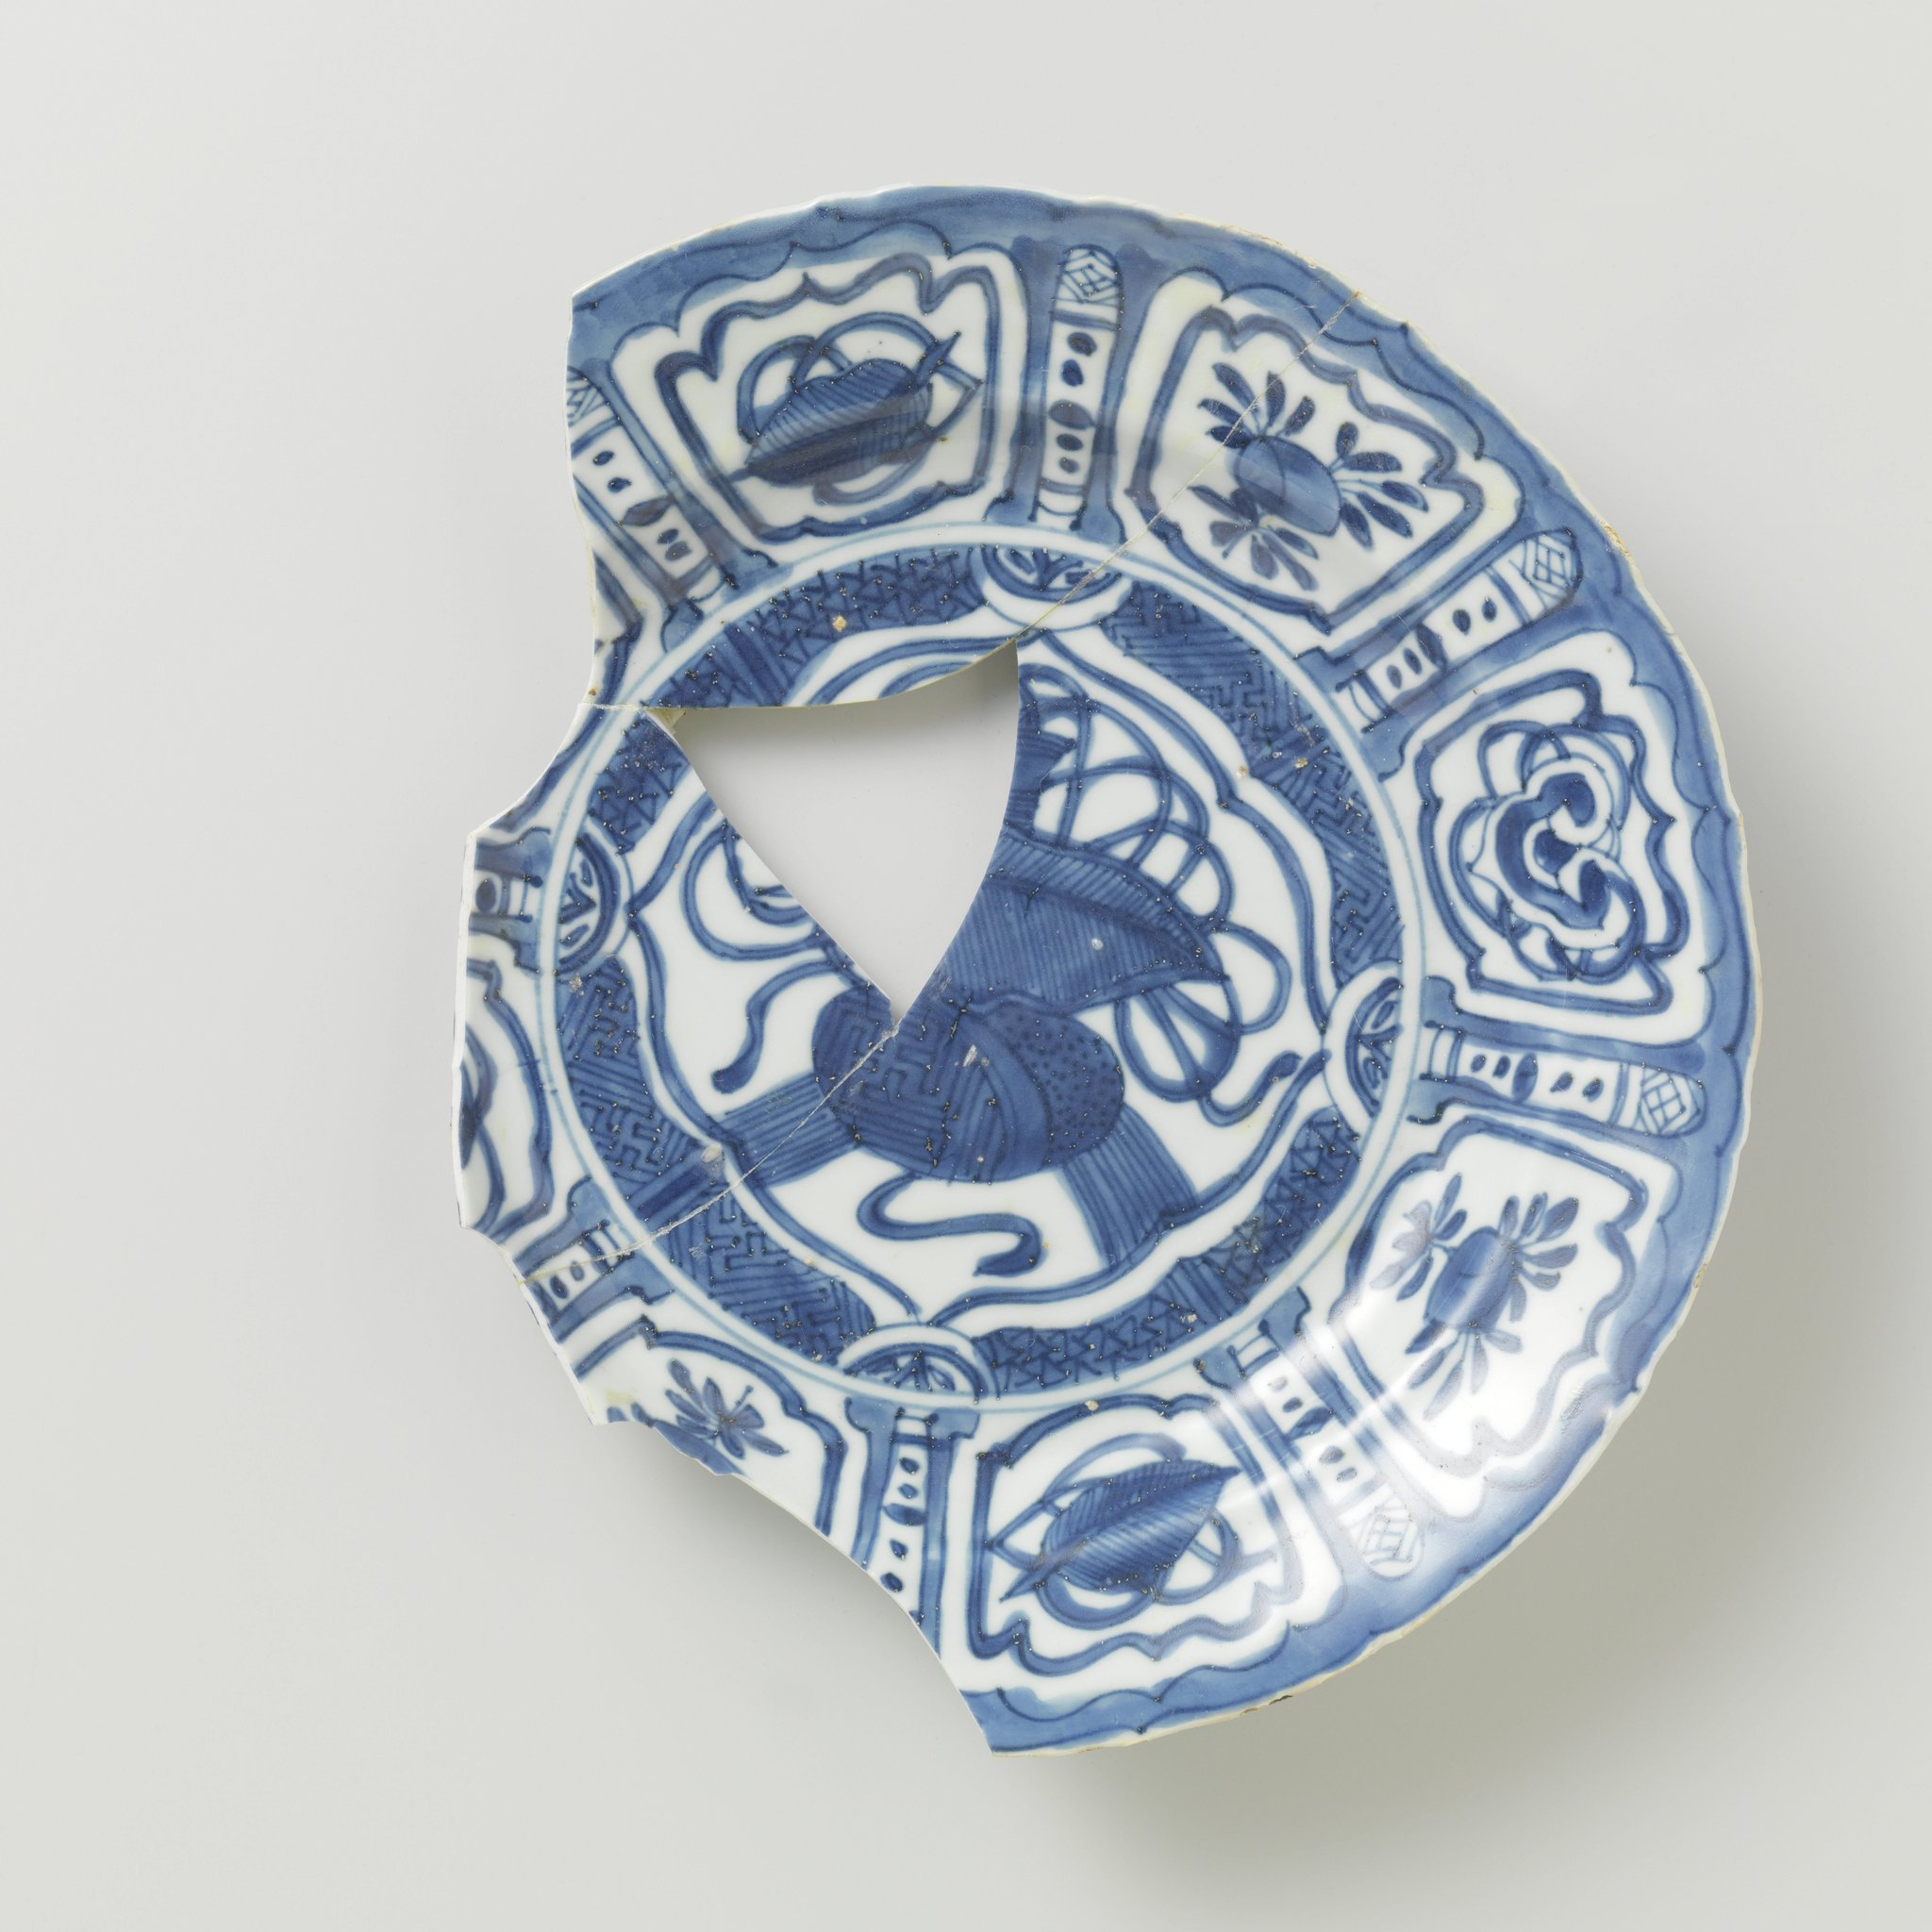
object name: plate dish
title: Bord uit V.O.C.-schip de 'Witte Leeuw'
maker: Anonymous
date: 1613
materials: bone china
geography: jingdezhen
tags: verenigde oostindische compagnie, sint-helena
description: A plate with a flattened rim. A four-sided scalloped medallion with rui heads and radial panels and diaper patterns. A central decoration of symbols. Panels decorated with flowers and symbols.